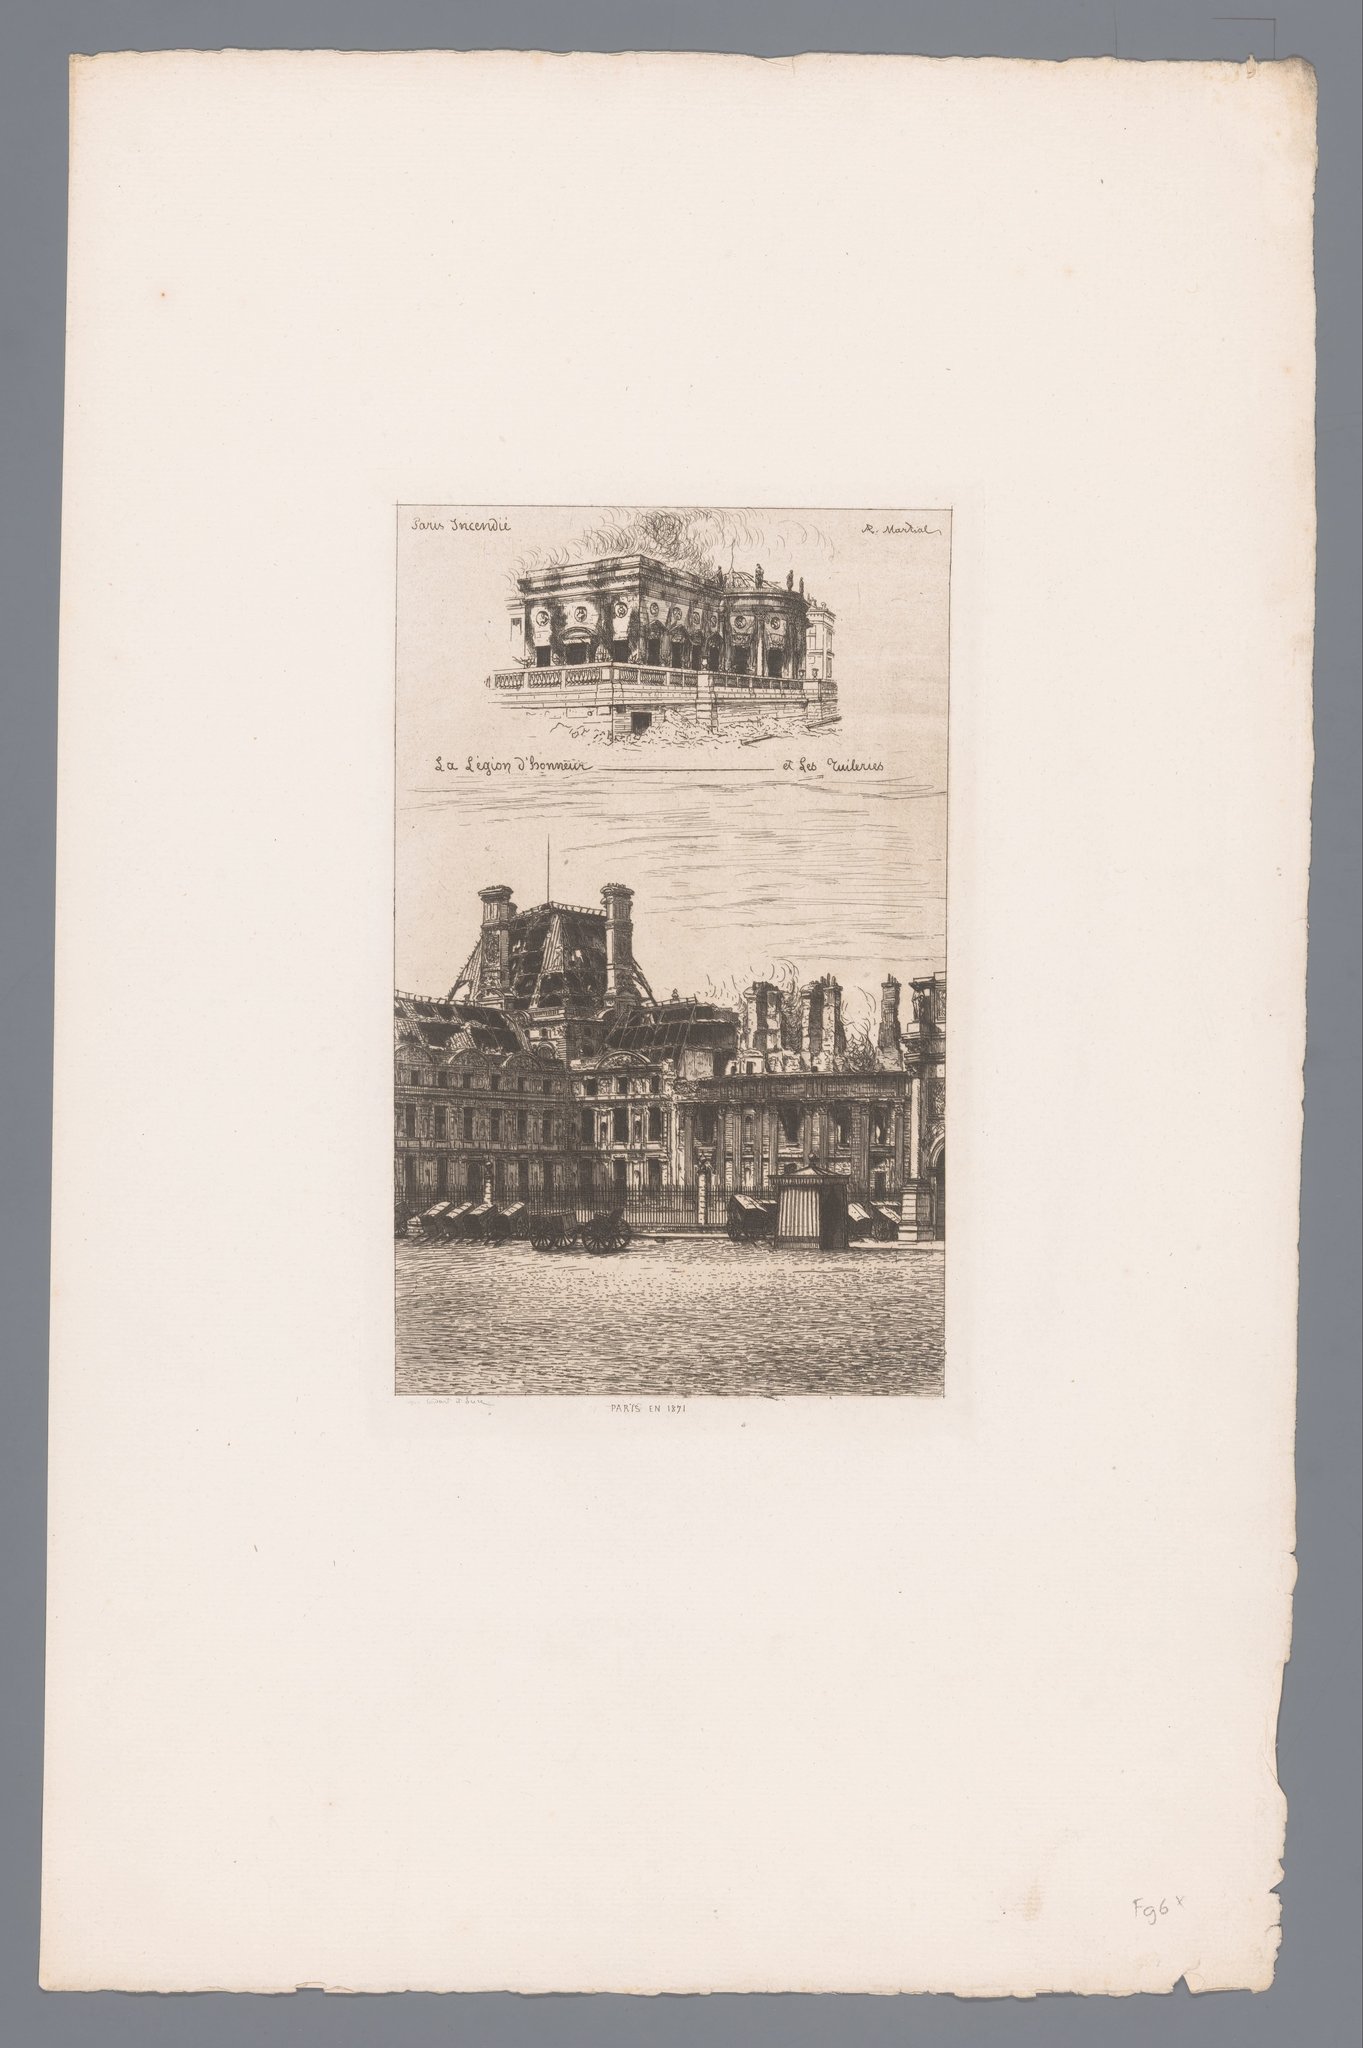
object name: print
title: Parijs in brand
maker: adolphe martial potémont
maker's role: print maker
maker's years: 1828-1883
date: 1838-1883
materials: paper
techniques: etching, intaglio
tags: on fire, ablaze, ruin of a building ~ architecture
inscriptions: collector's mark: Lugt 2228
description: De prent bevindt zich in een omslag en maakt deel uit van een twaalfdelige serie prenten met als onderwerp het brandende Parijs tijdens de Commune in 1871, samengesteld en uitgevoerd door Martial Potémont.